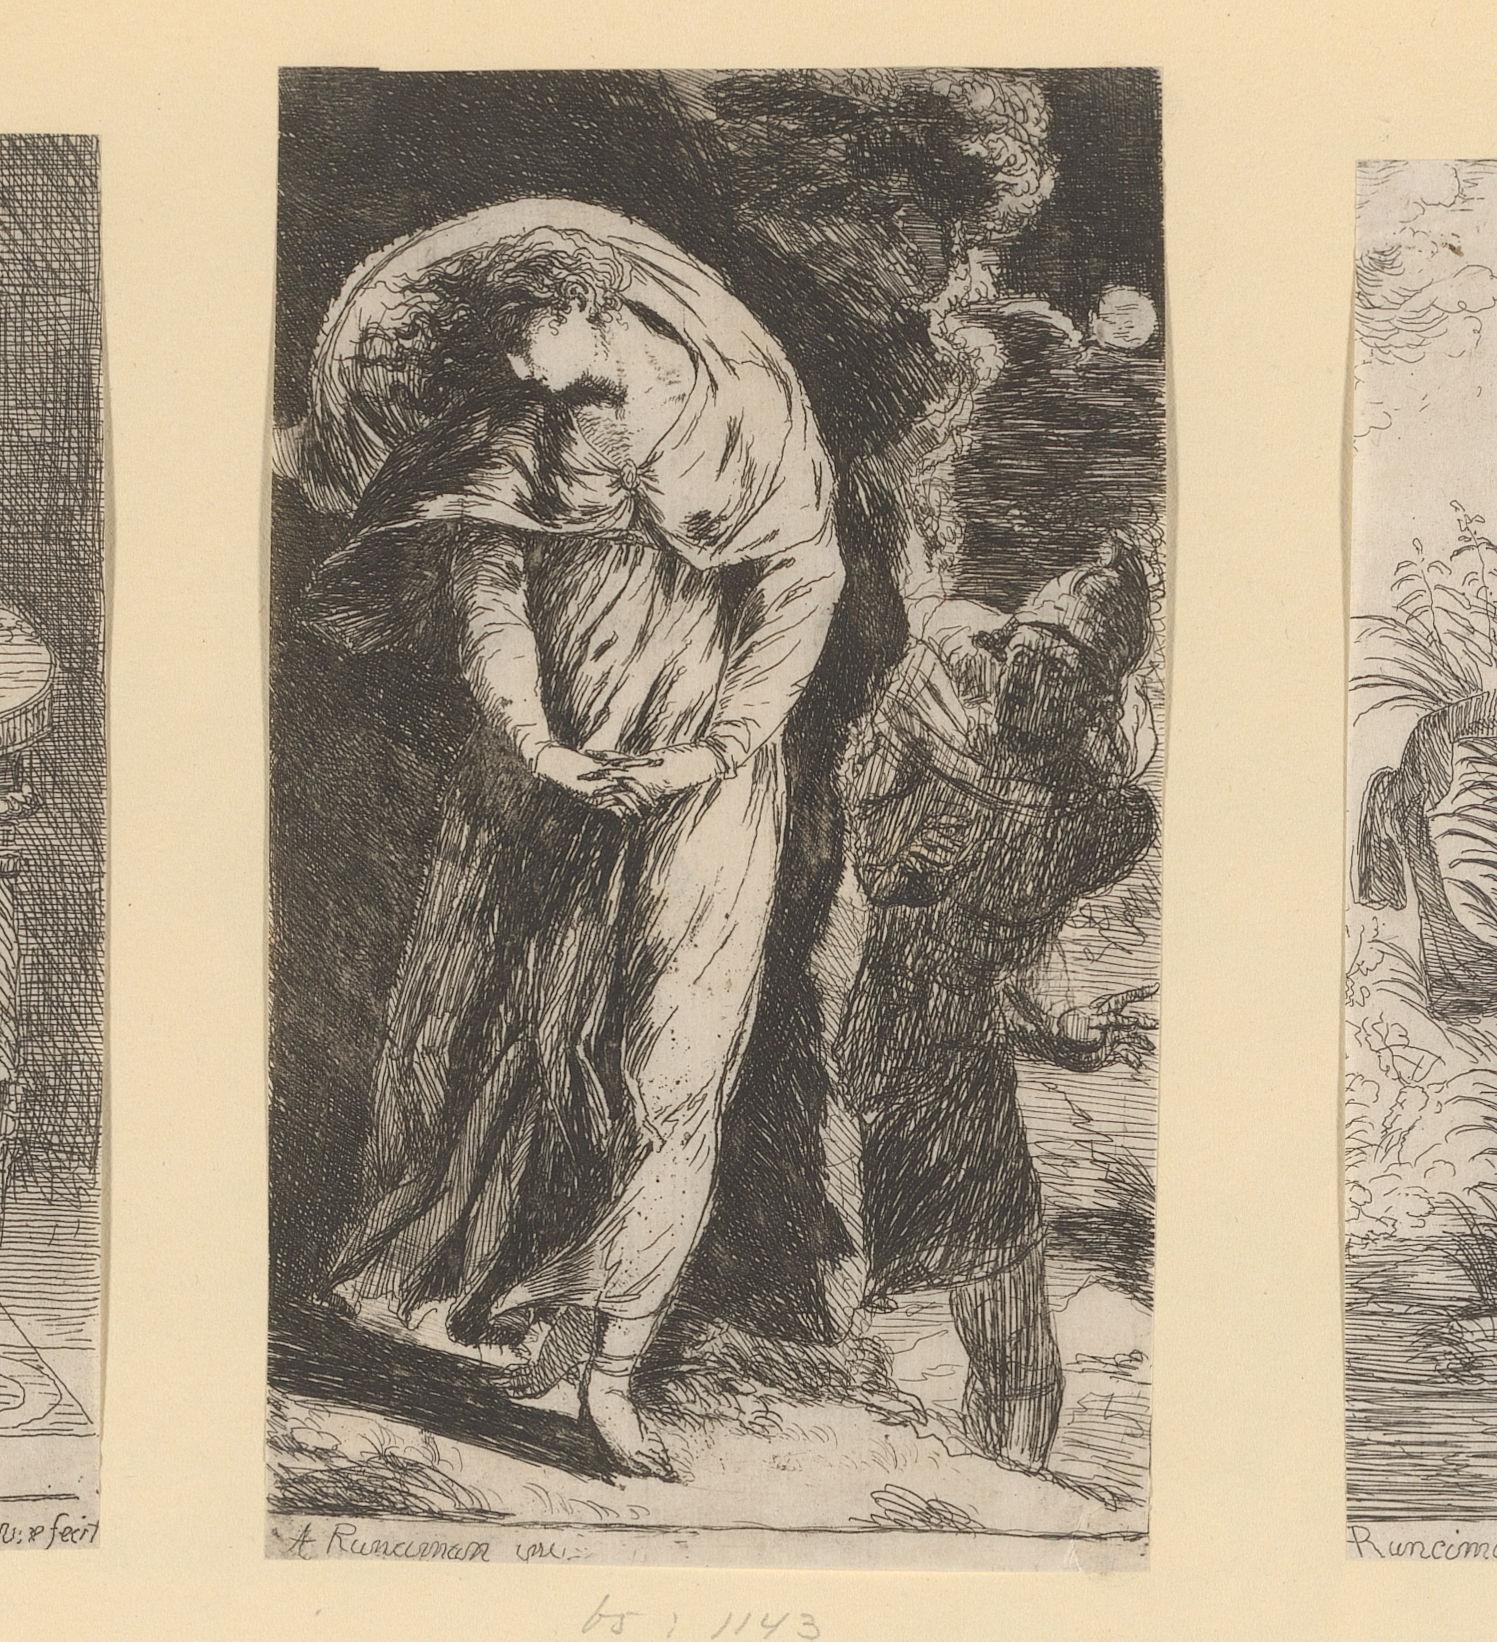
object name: print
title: Fingal vindt Conban-Cargla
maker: alexander runciman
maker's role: draughtsman, print maker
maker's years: 1736-1785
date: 1746-1785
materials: paper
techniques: etching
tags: (scenes from) specific works of literature (with author, title), fingal, king of morven, father of ossian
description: Prent maakt mogelijk deel uit van een serie van 200 prenten. Deze serie is onder de titel 'A Collection of two hundred original etchings' voor het eerst uitgegeven door J.M. Greery in 1816.